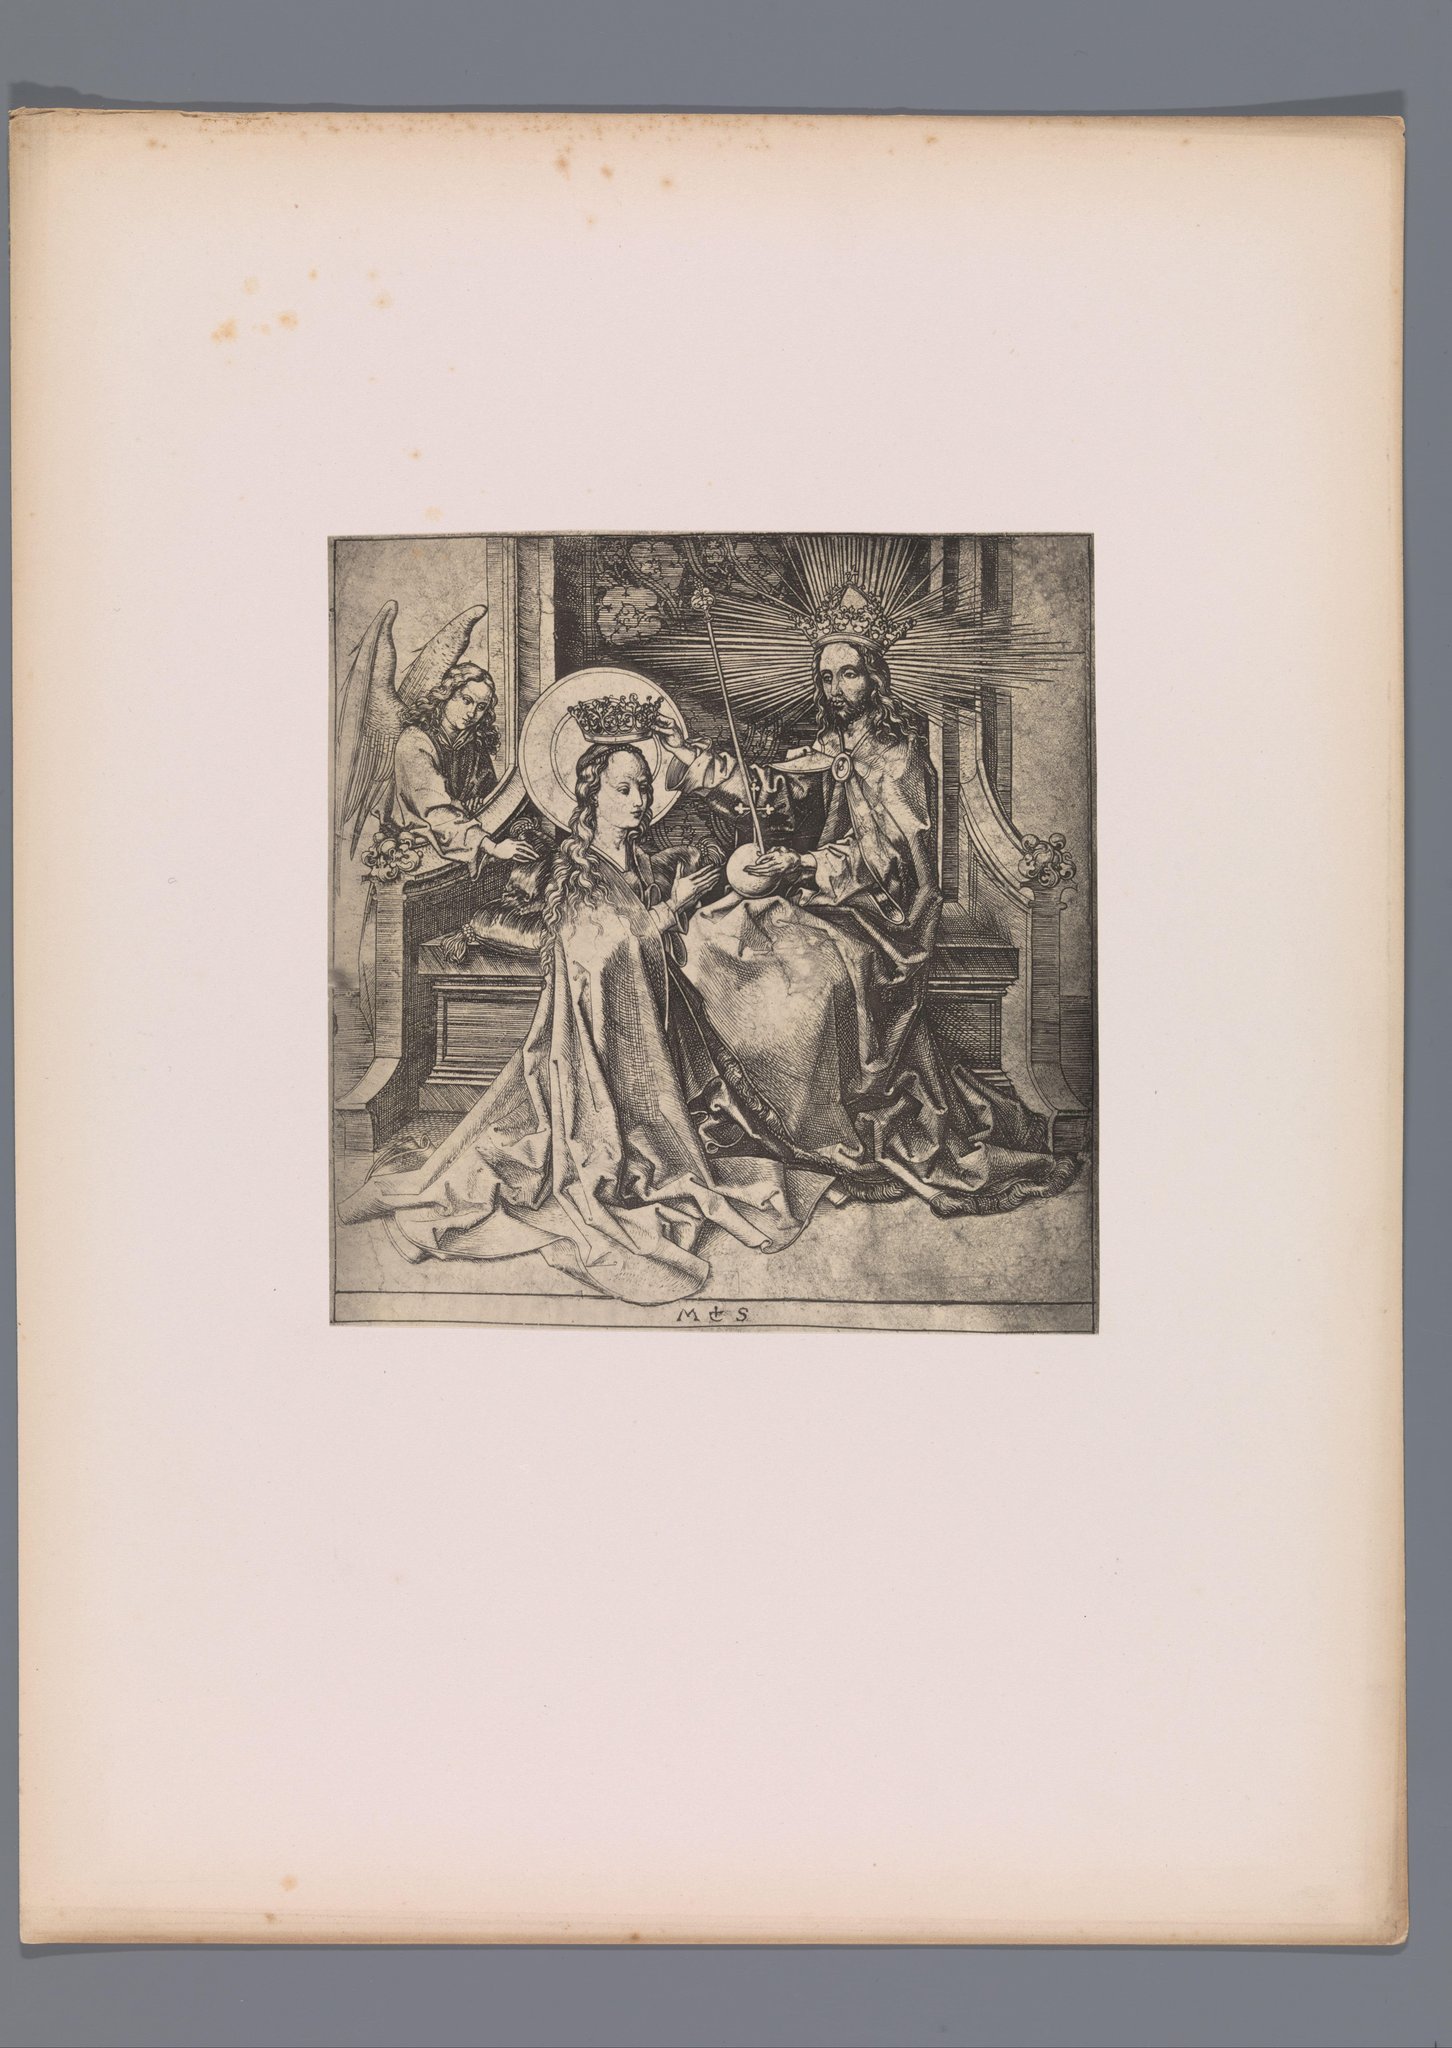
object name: reproduction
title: Reproductie van een prent van Christus die Maria kroont door Martin Schongauer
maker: martin schongauer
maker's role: print maker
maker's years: 1430-1491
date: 1867-1872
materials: paper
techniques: woodburytype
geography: brussels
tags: coronation of mary by christ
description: Deze prent maakt deel uit van een omslag met 24 prenten op 24 bladen.